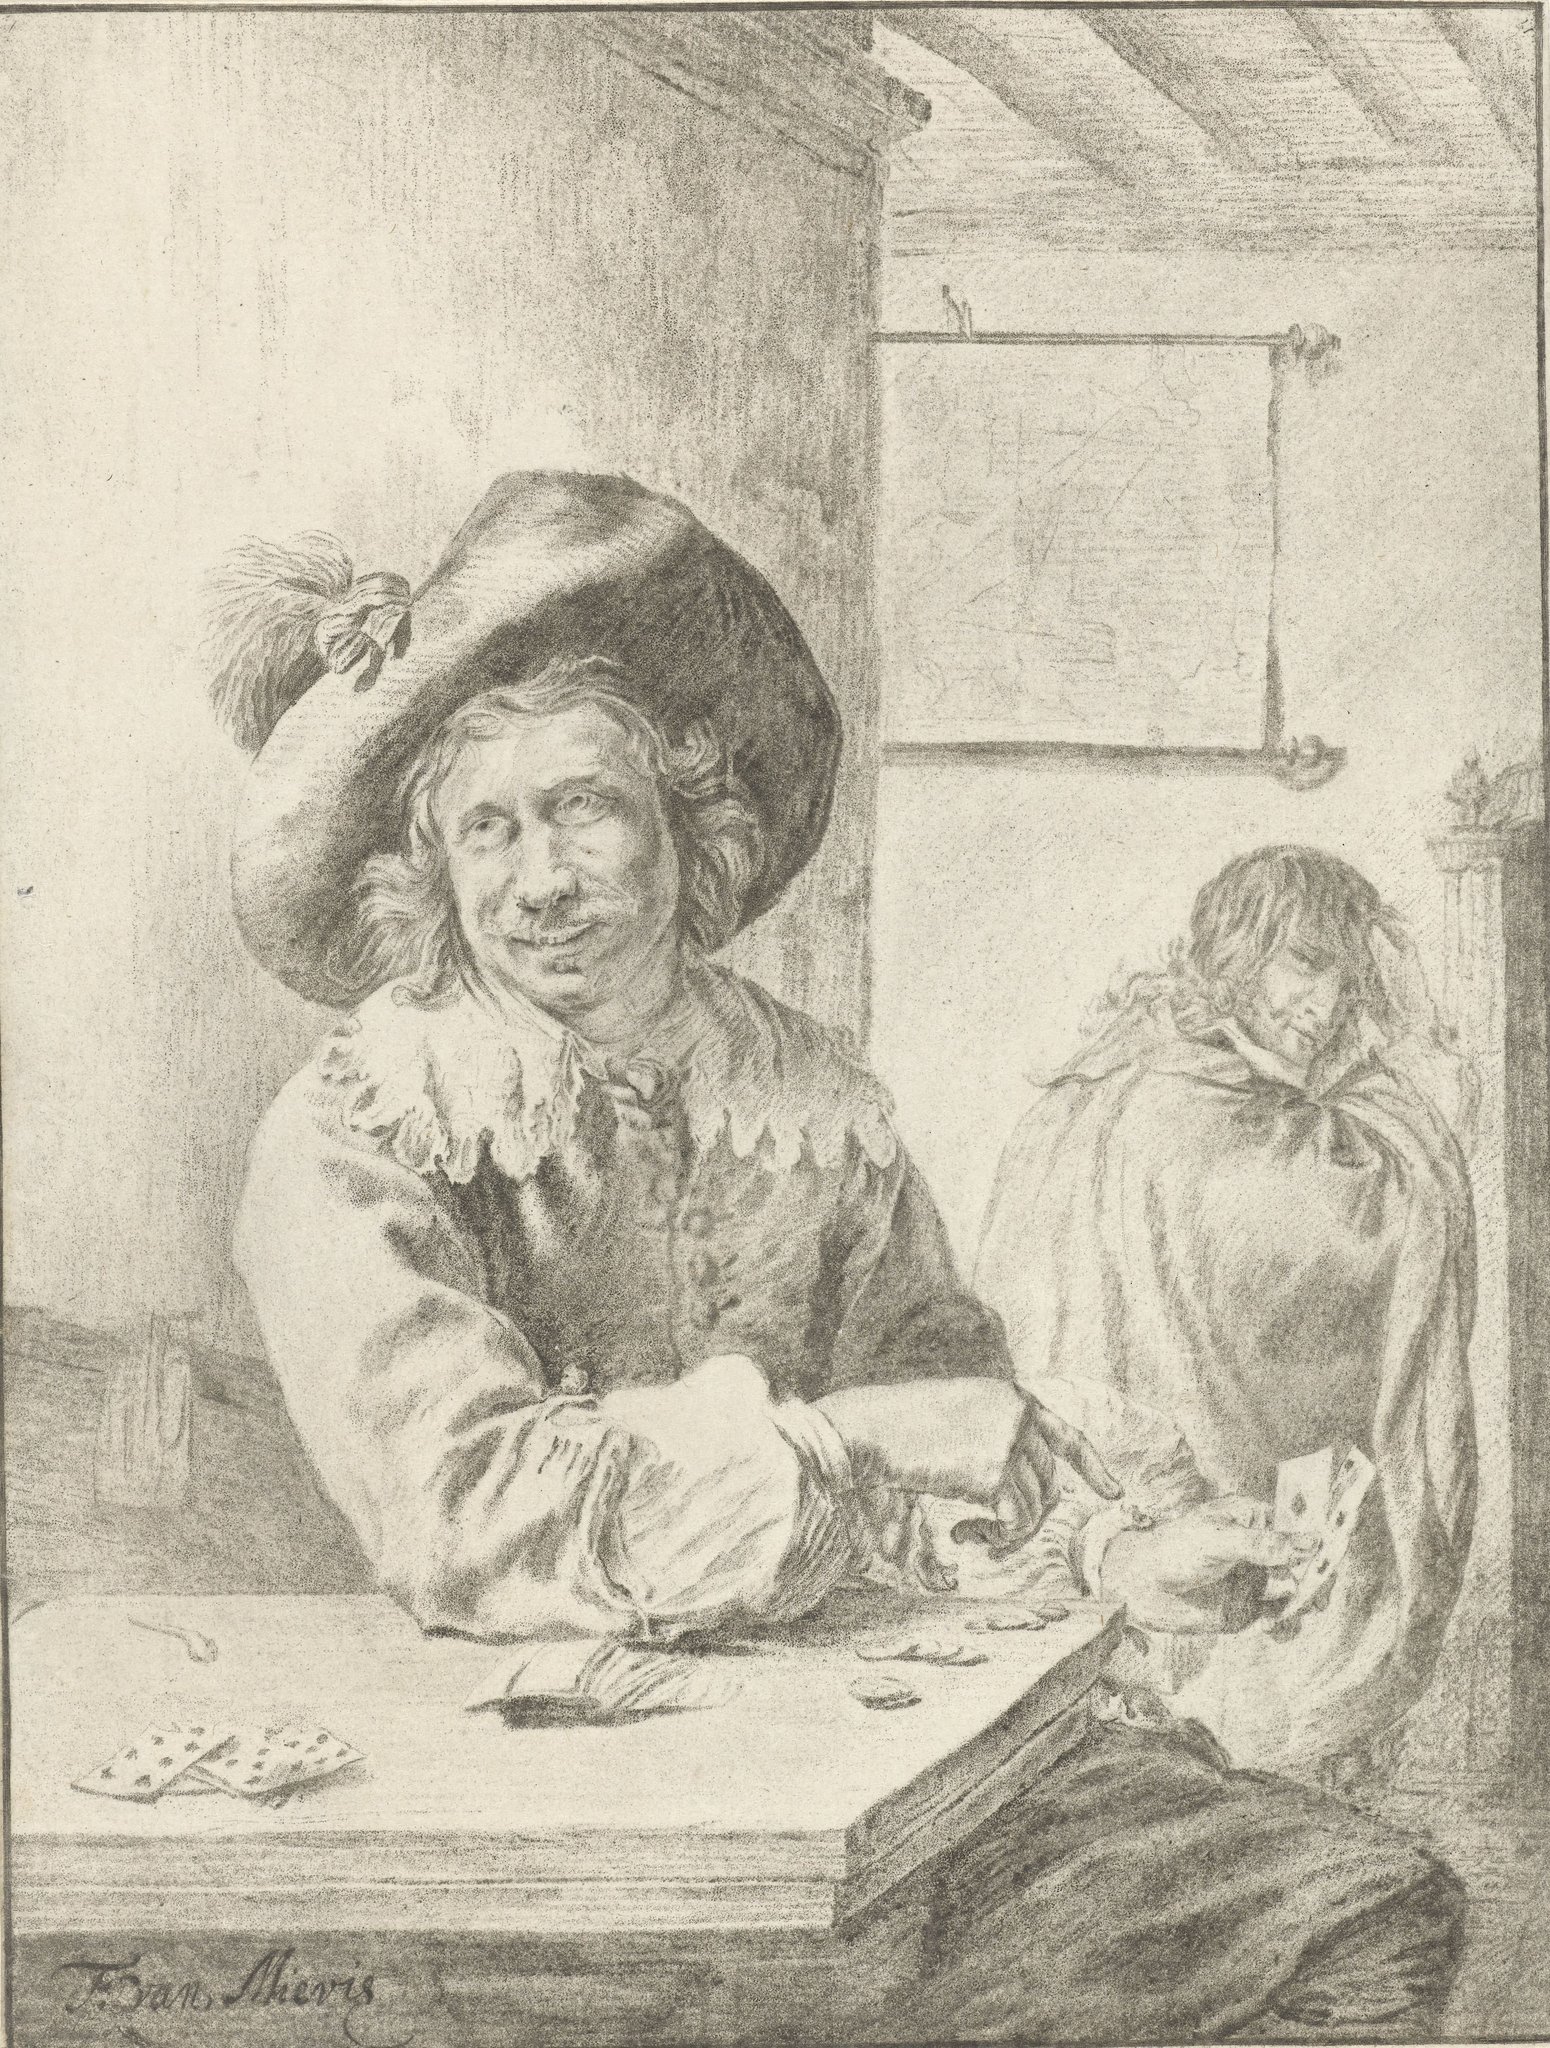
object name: print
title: Kaartspelers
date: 1777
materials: paper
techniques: printmaking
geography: amsterdam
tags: playing-cards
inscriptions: inscription: ‘Frs. V. Mieres. del. 1663. Ploos V. Amstel, J. C. F: 1777.’, collector's mark: Lugt 240, collector's mark: Lugt 2725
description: Een kaartspeler met speelkaarten in de hand en op tafel. Op de achtergrond een man.